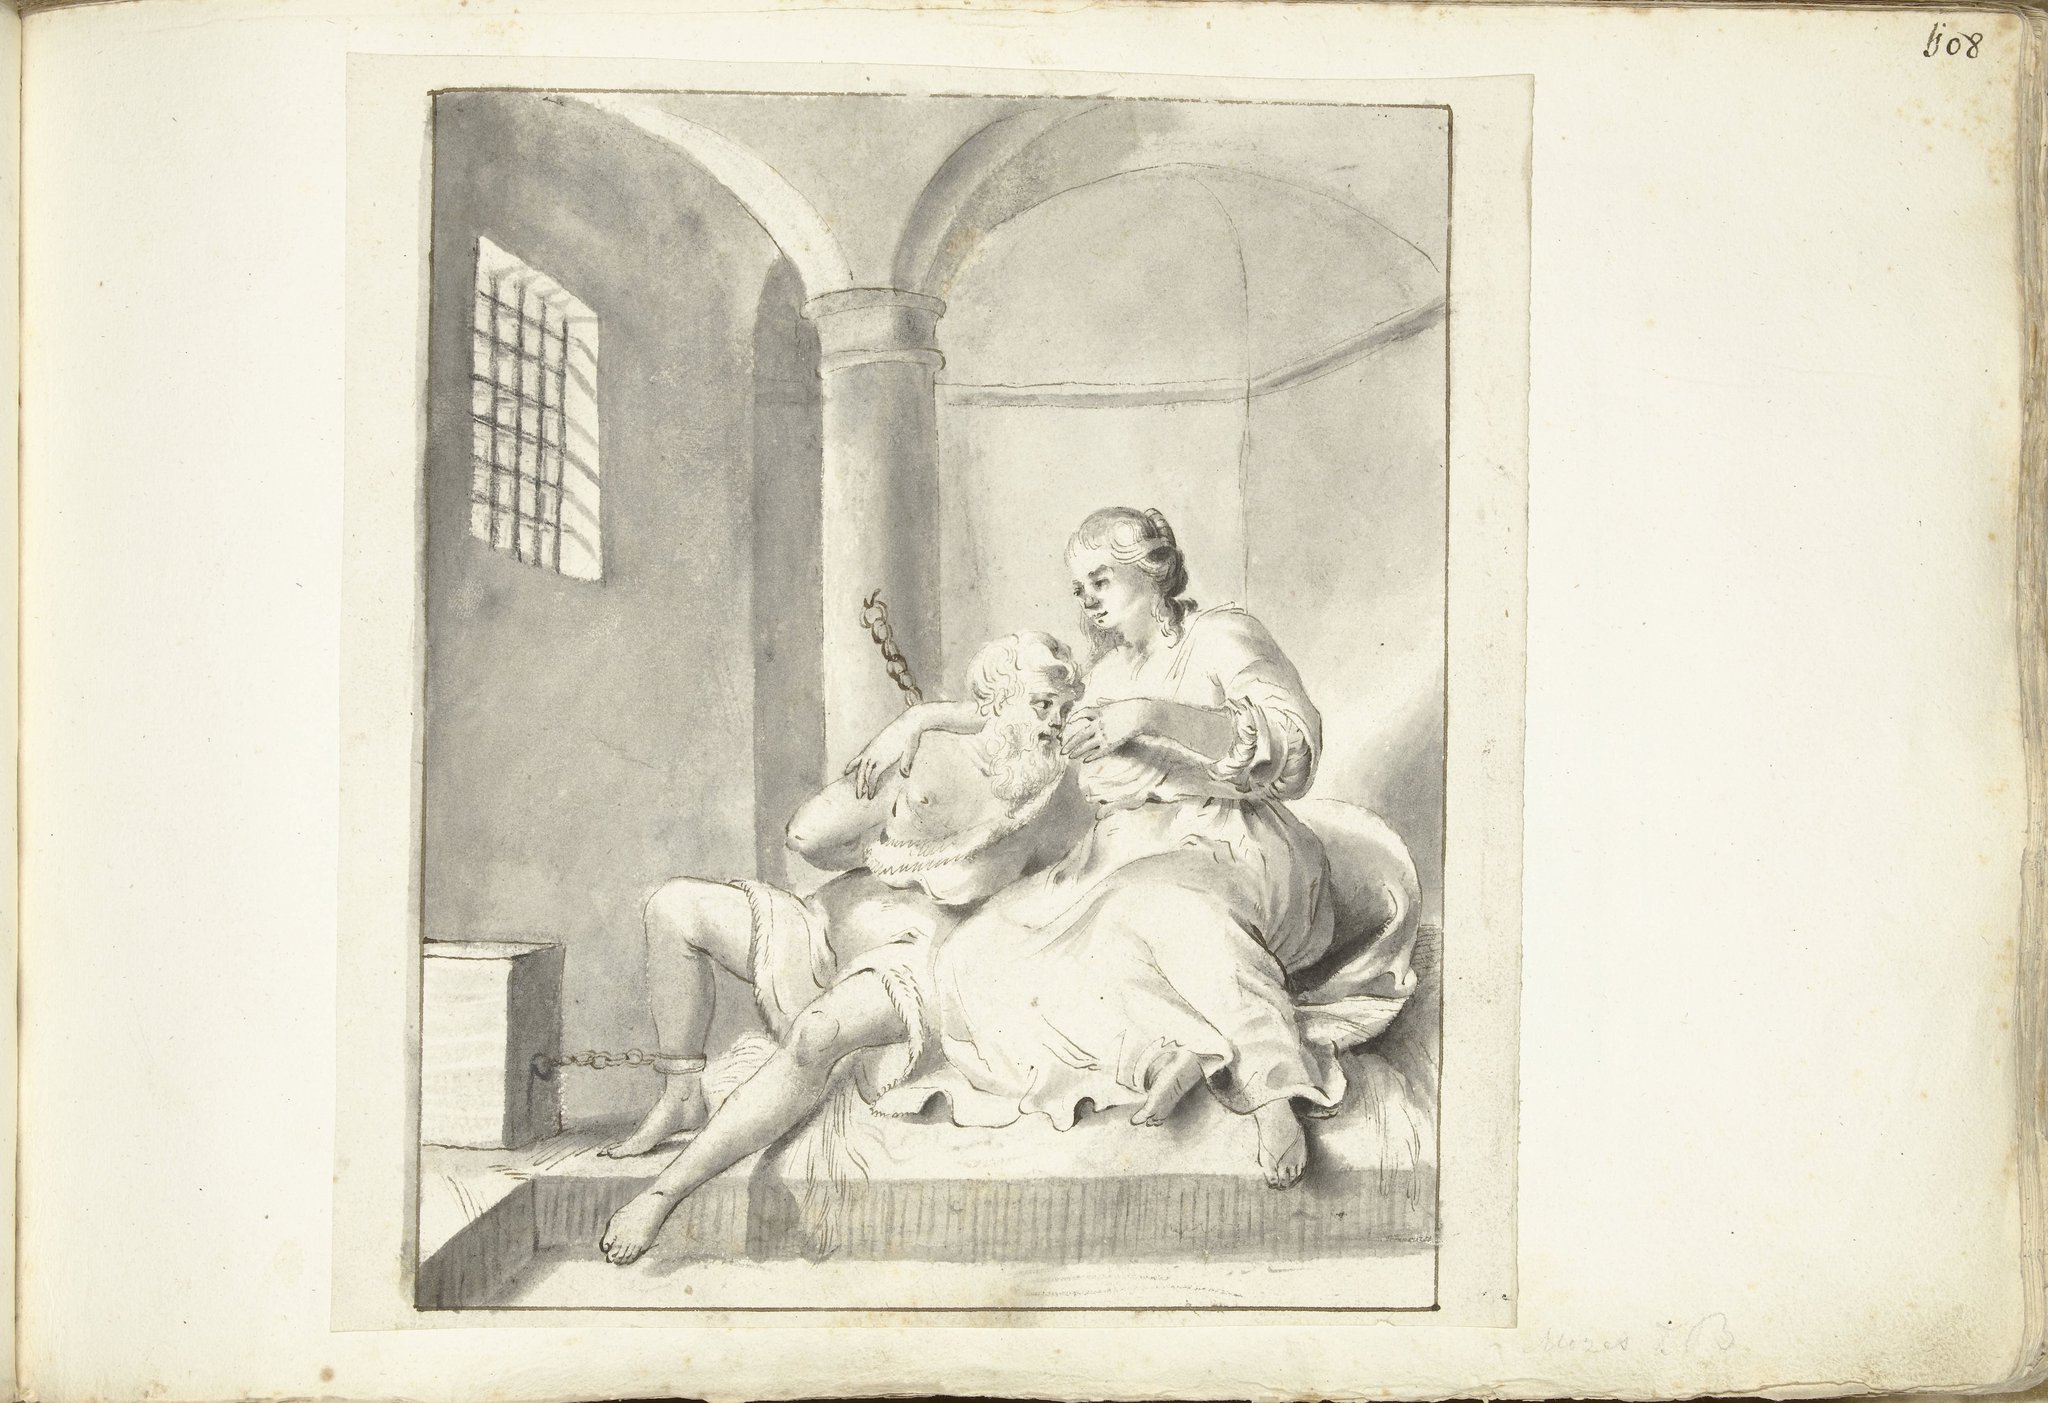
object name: drawing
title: Cimon en Pero (Caritas Romana)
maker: moses ter borch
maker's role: draughtsman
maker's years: 1645-1667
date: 1659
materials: ink, paper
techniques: brush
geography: zwolle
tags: pero suckling cimon ('caritas romana')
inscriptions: annotation: ‘Mozes T B’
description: De tekening is opgeplakt in het Familie-plakboek.